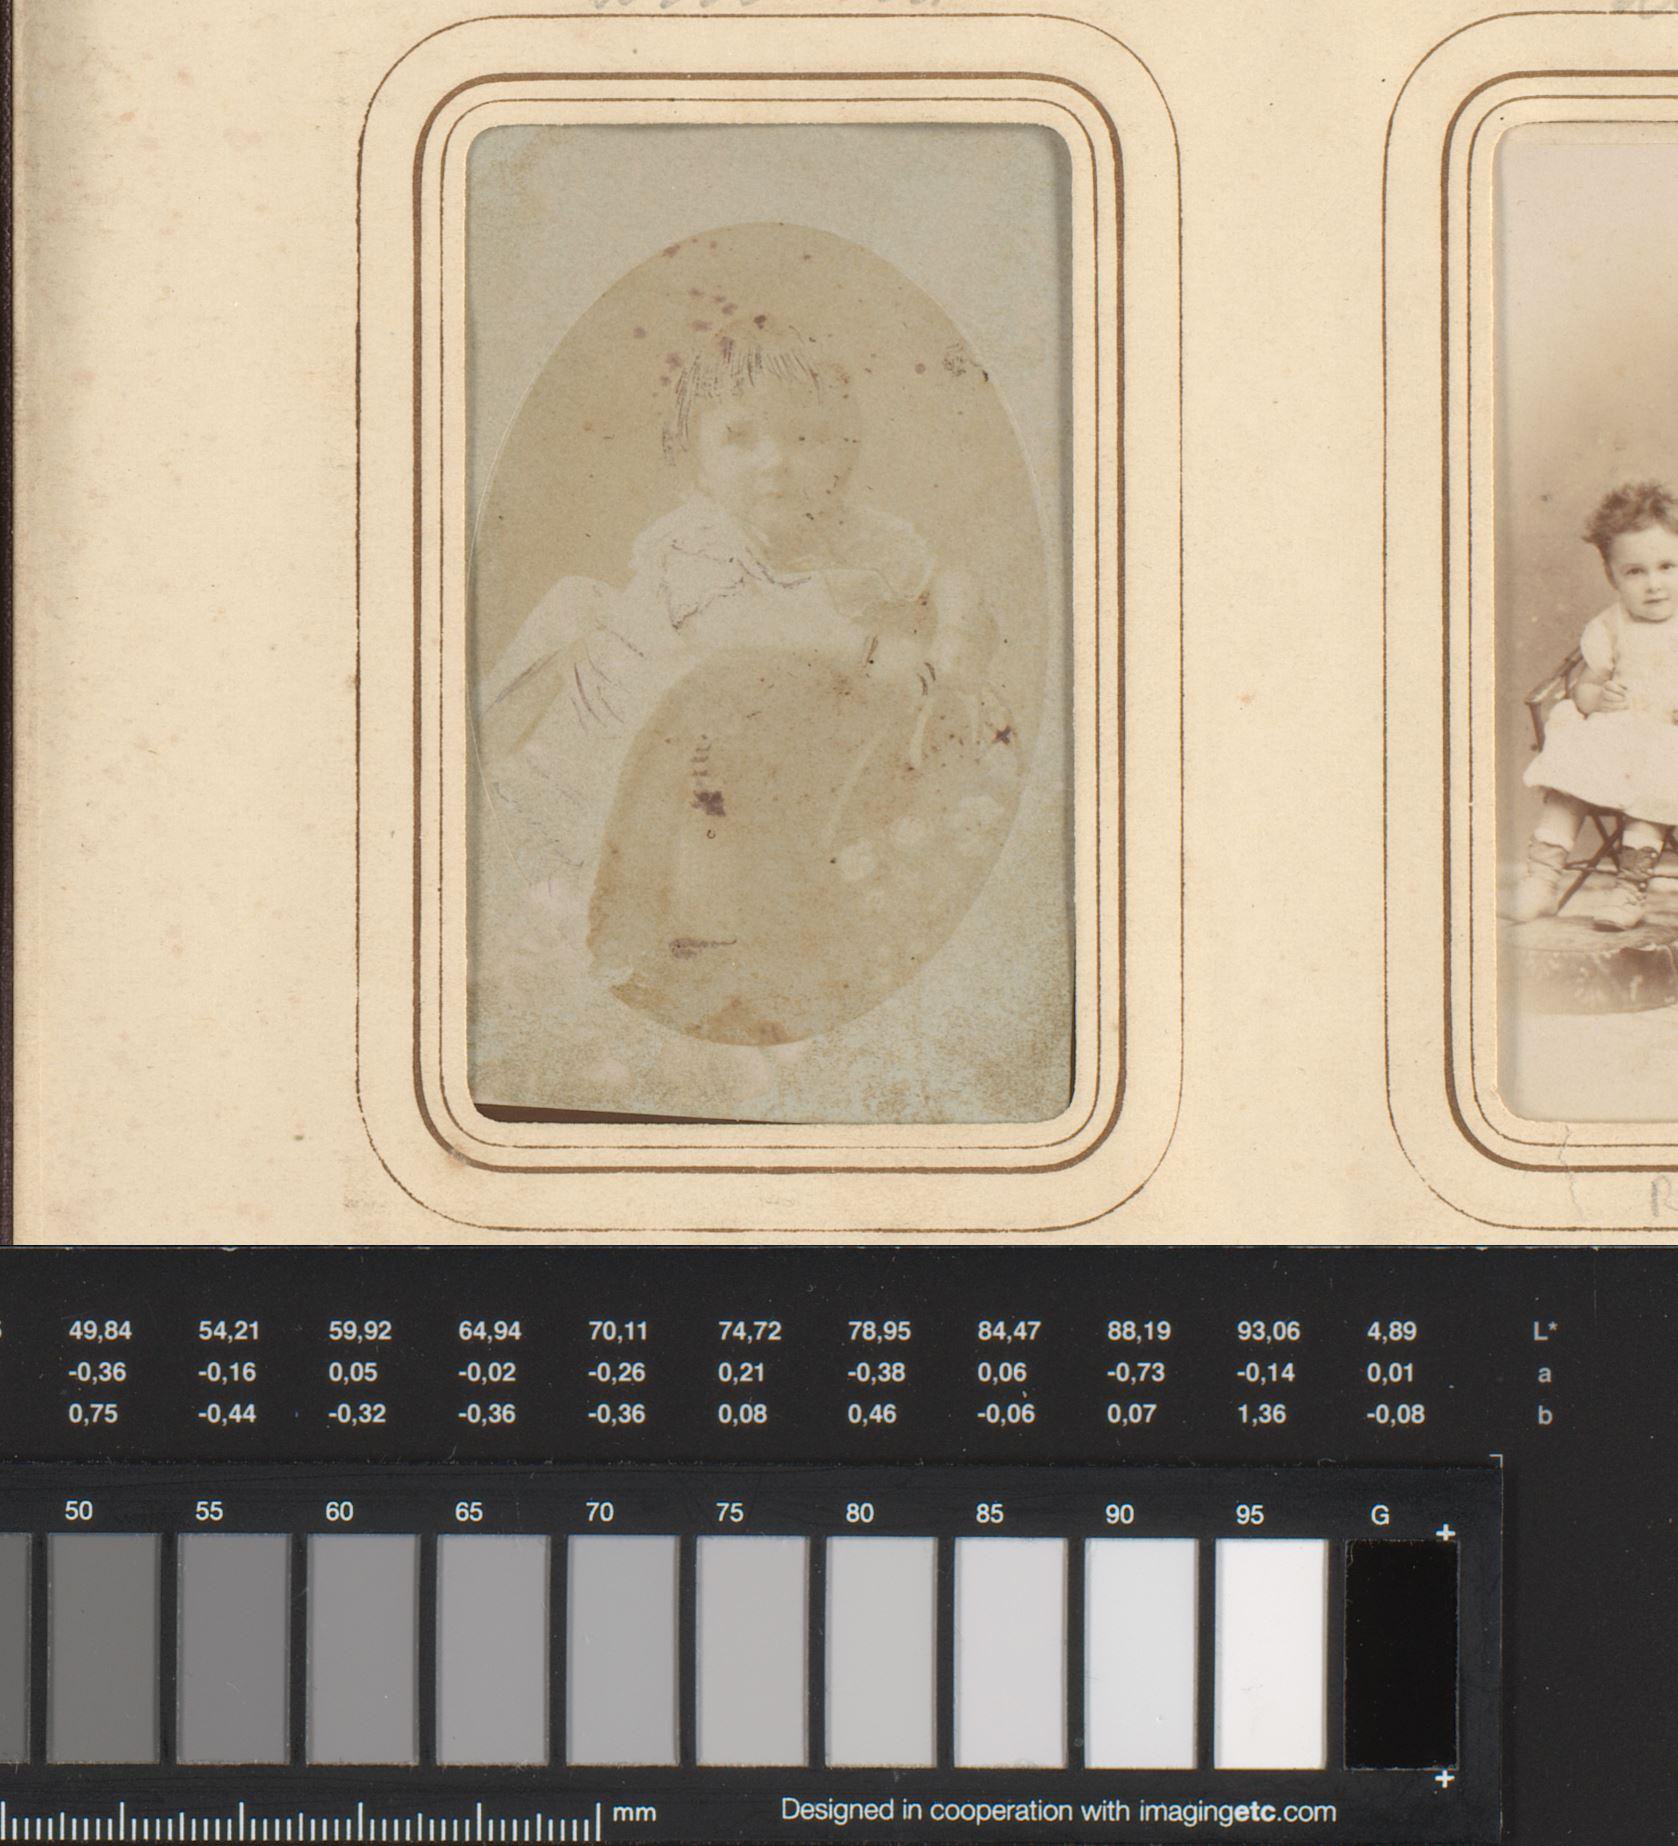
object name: carte de visite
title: Portret van een kind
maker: johannes ephraim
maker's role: fotograaf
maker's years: 1838-1921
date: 1870-1890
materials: cardboard, photographic support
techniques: albumen print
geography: arnhem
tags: child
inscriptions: inscription: ‘J. Ephraim Jne / Arnhem’, inscription: ‘J. Ephraïm Jne / Photographe de S.M. le Roi / Rijnkade 53. / Arnhem./ Les clichés sont conservés.’